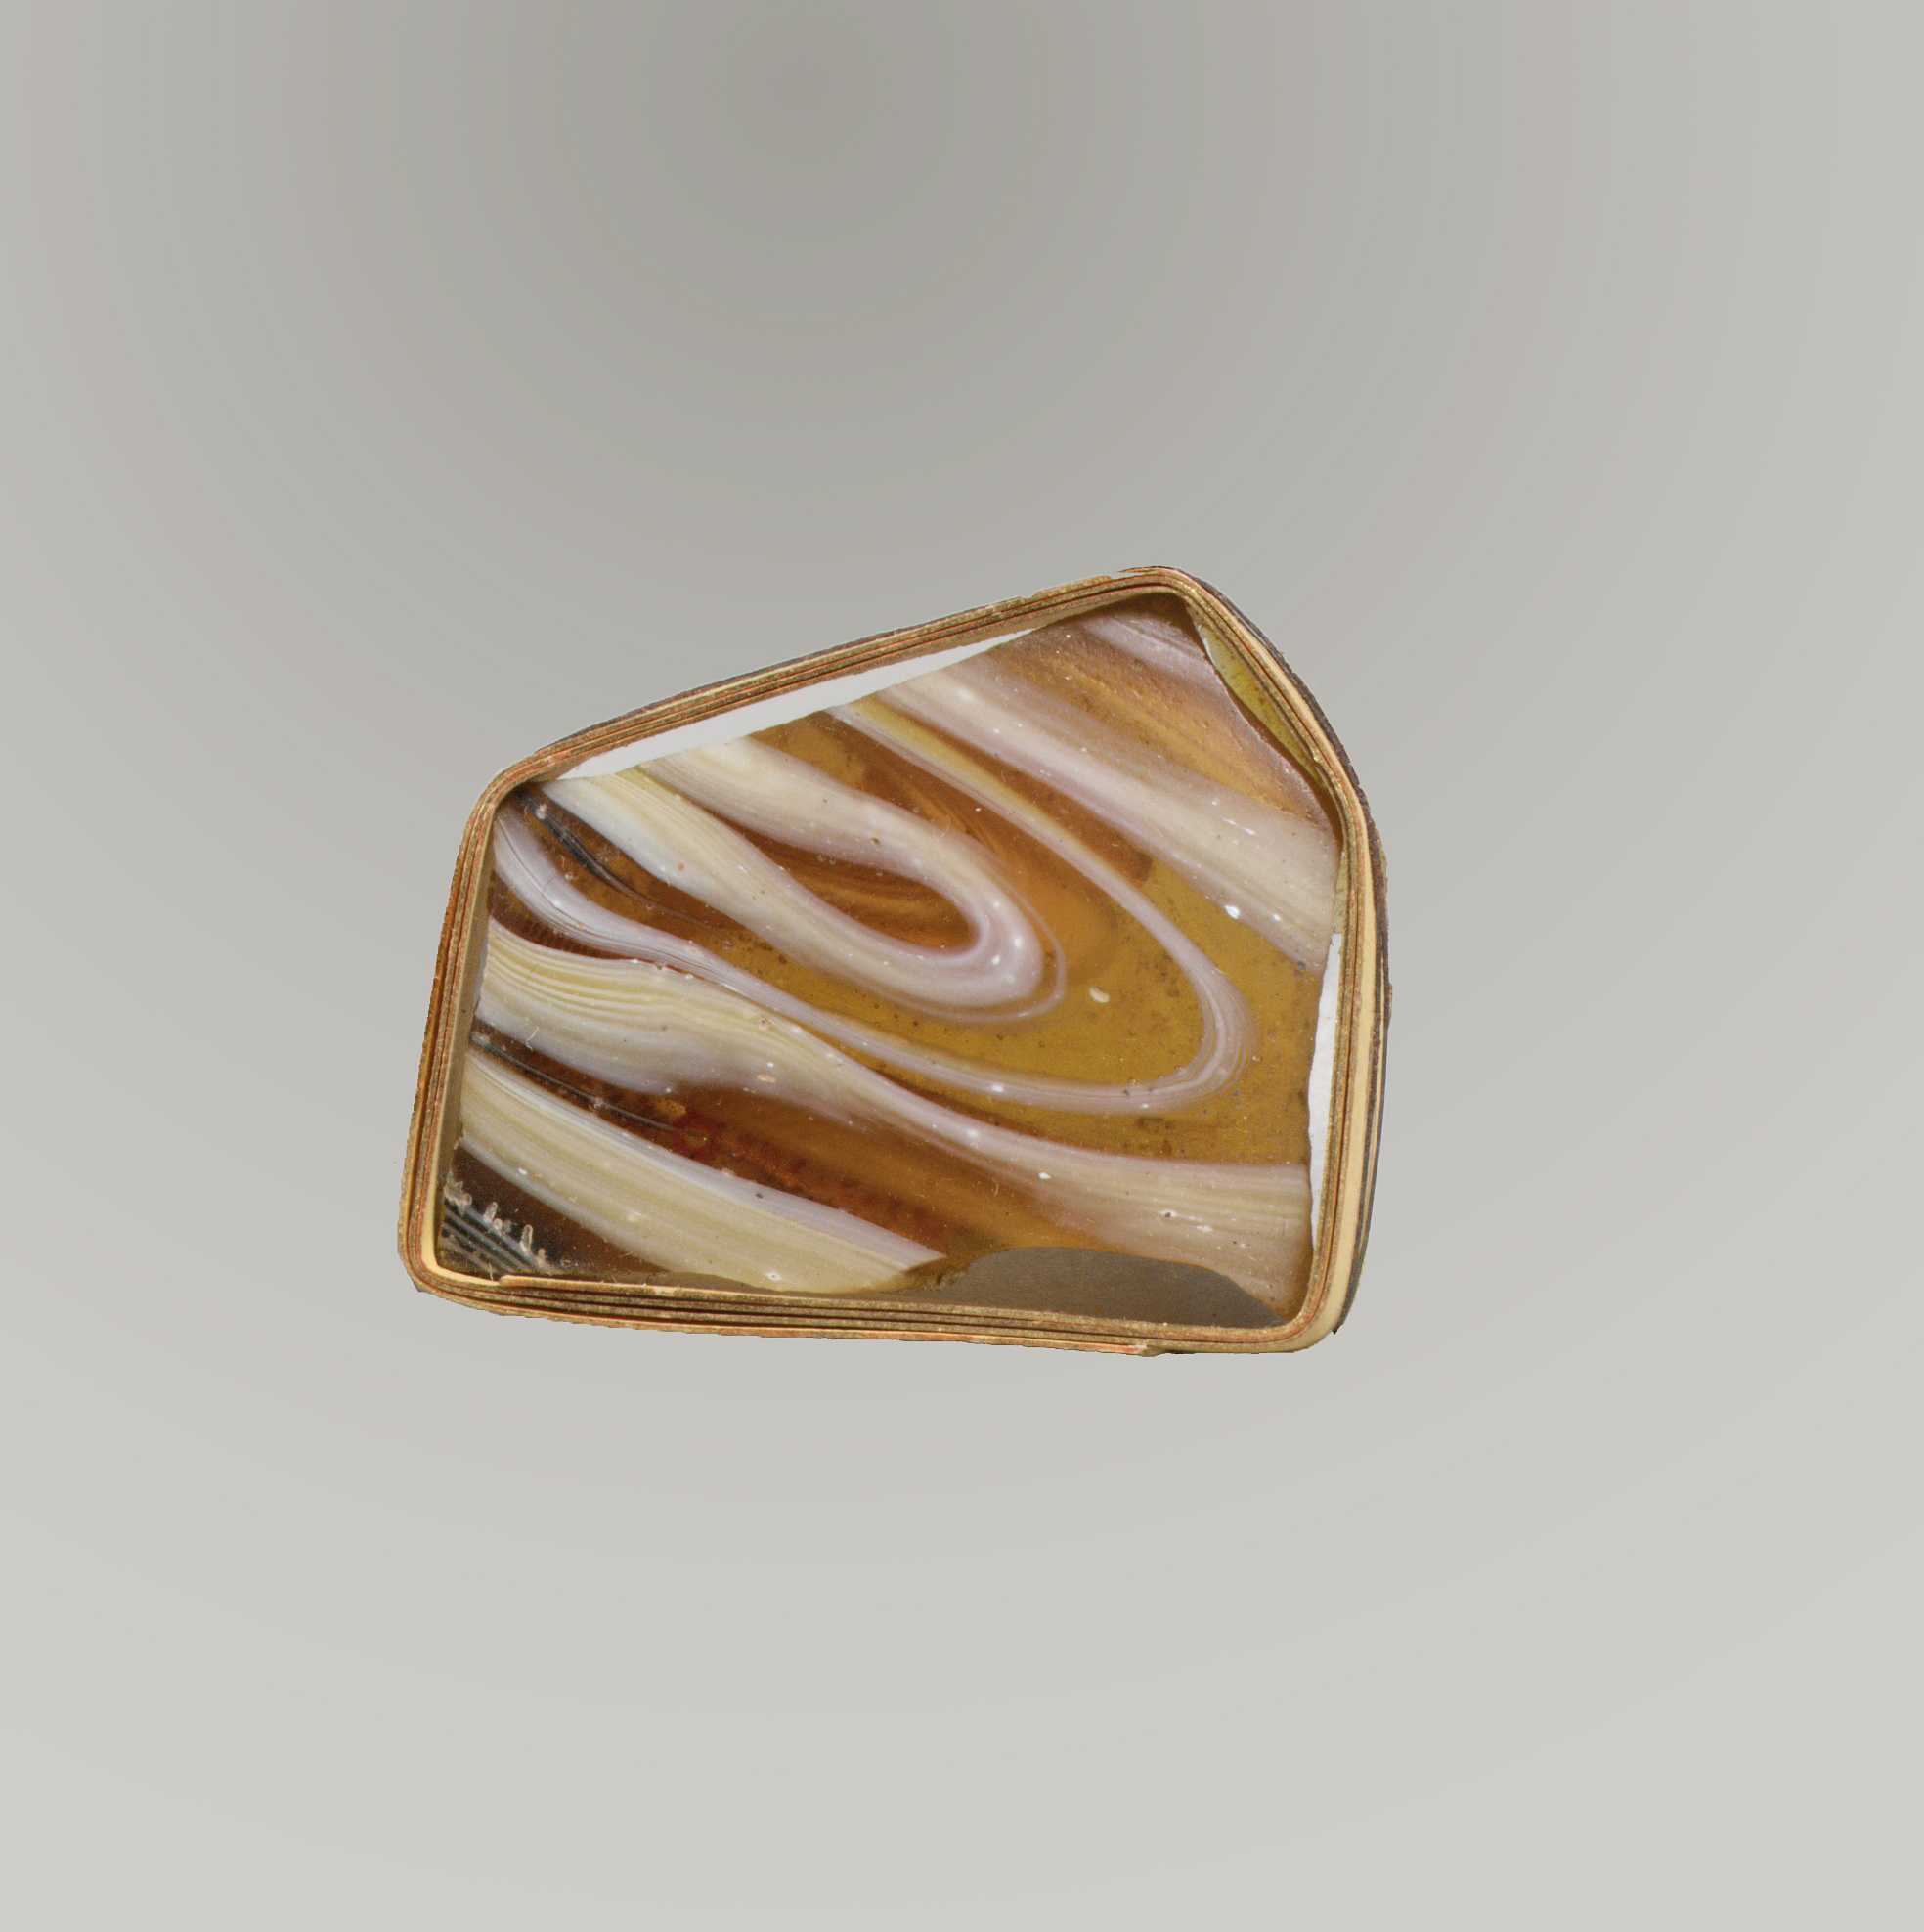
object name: fragment, mosaic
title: Glass mosaic fragment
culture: roman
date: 34 BCE-33 CE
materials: glass